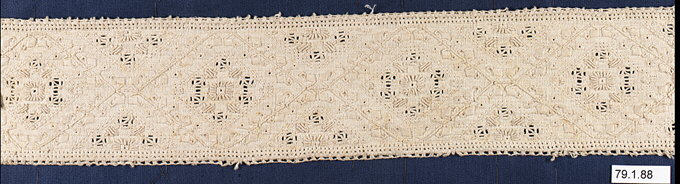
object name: band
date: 1501-1600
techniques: embroidery